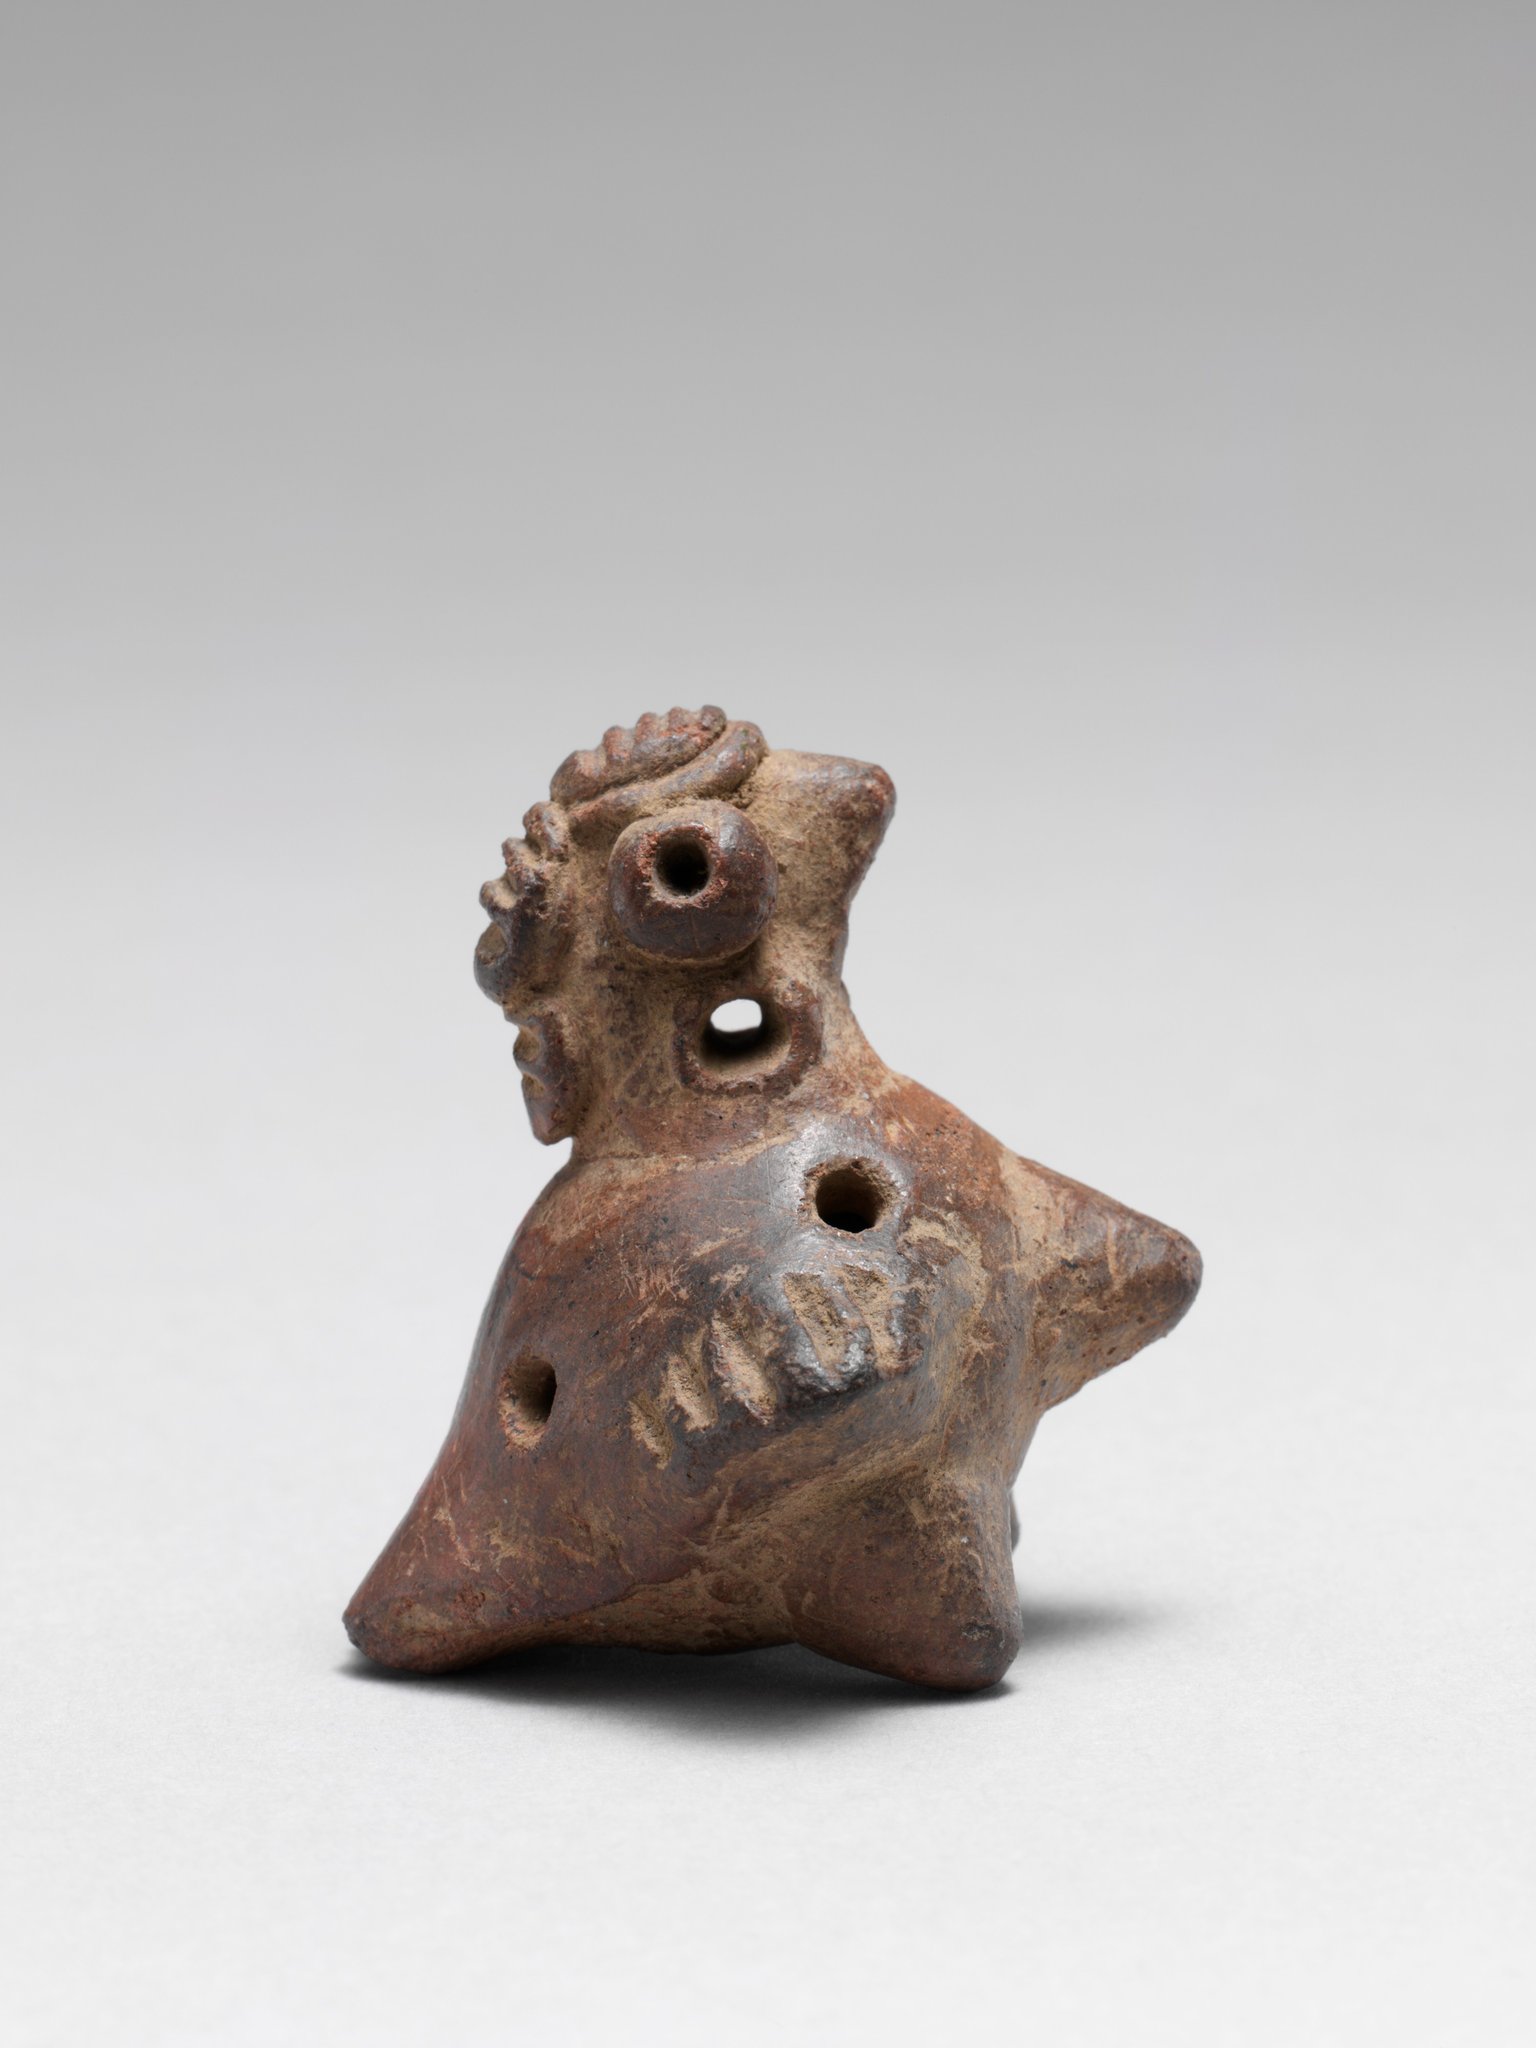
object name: pottery whistle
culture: costa rican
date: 800-1500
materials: clay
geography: costa rica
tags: birds